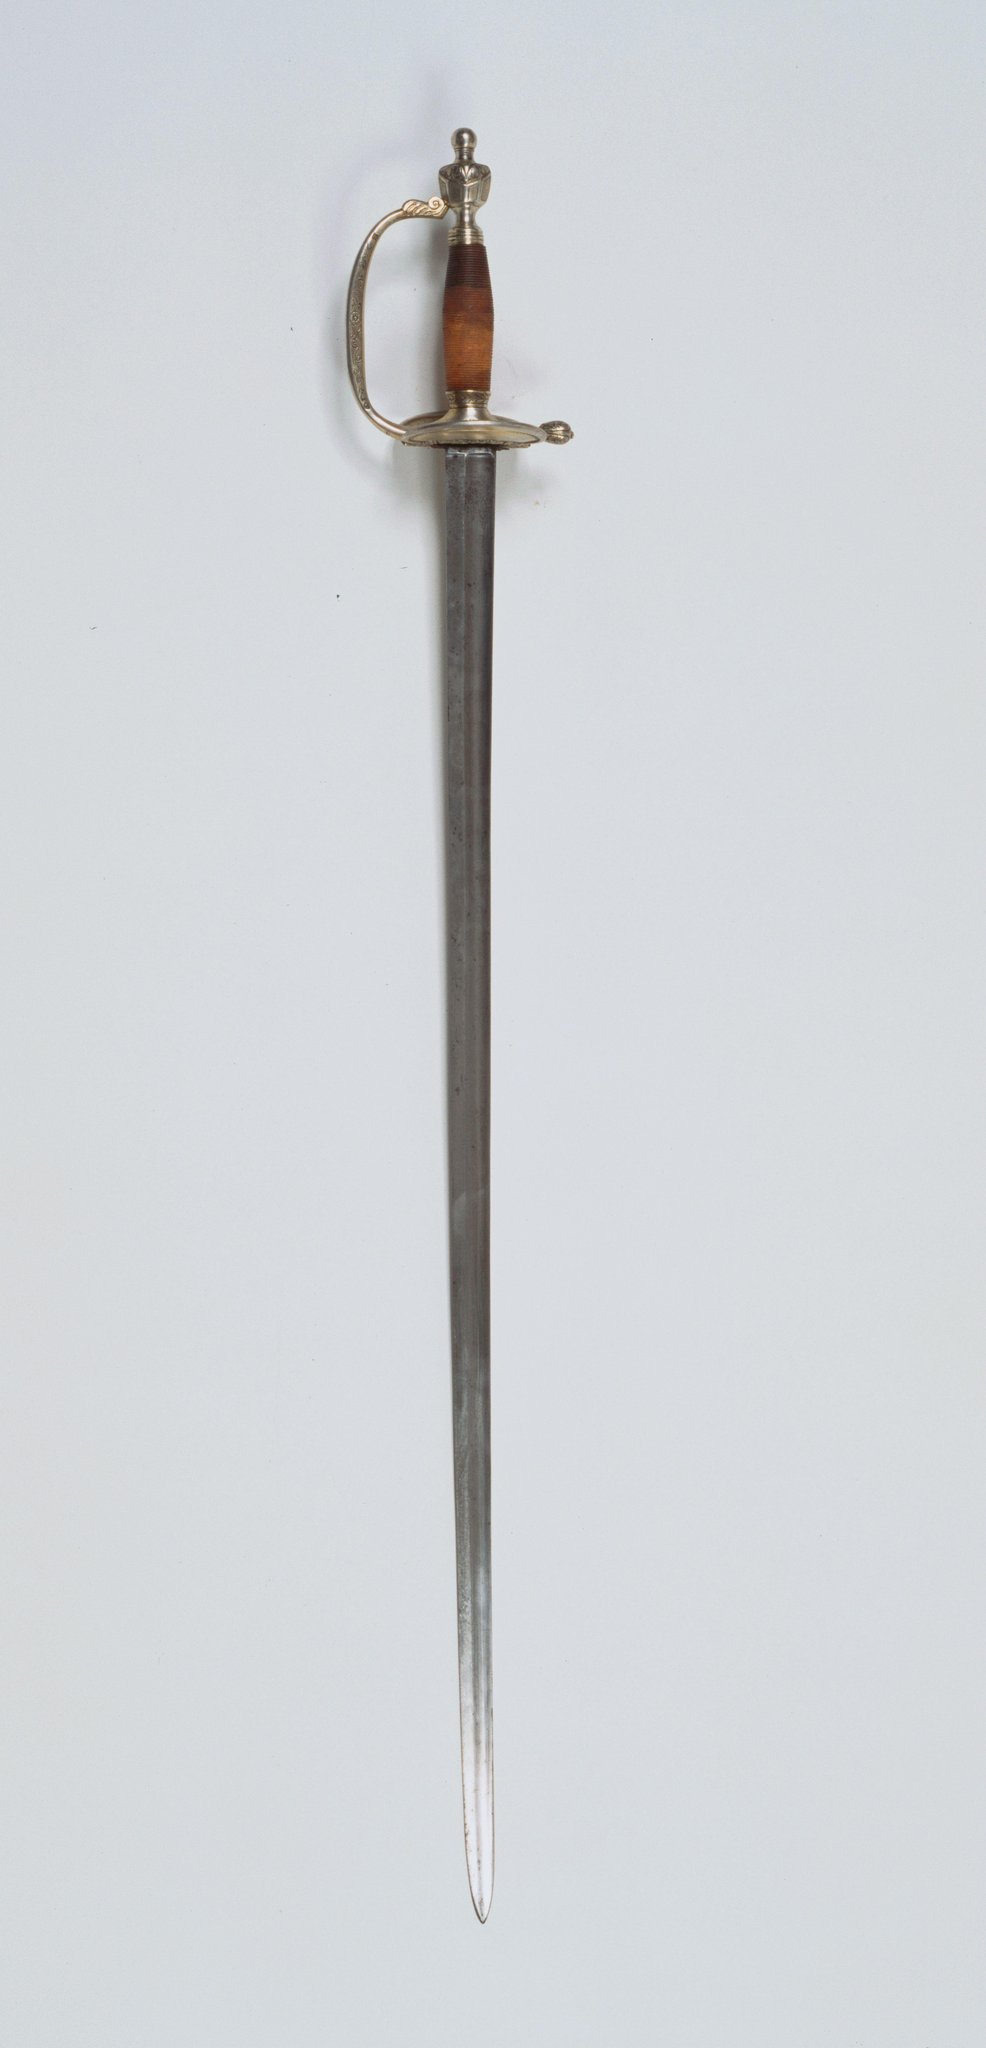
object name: sword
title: Officiersdegen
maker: Anonymous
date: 1800-1900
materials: copper, iron, wood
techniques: engraving, gilding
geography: western europe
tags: netherlands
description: Degen, algemeen leger model, verzilverd en met opschrift op de scharnierende stootplaat: "Het Korps Officieren der 15e Afdeling Nationale Infanterie, aan hunne brave Kolonel Baron des Tombe". Geribbelde greep van hout, koperen stootplaat met zijbeugel en diamantvormige greepknop.